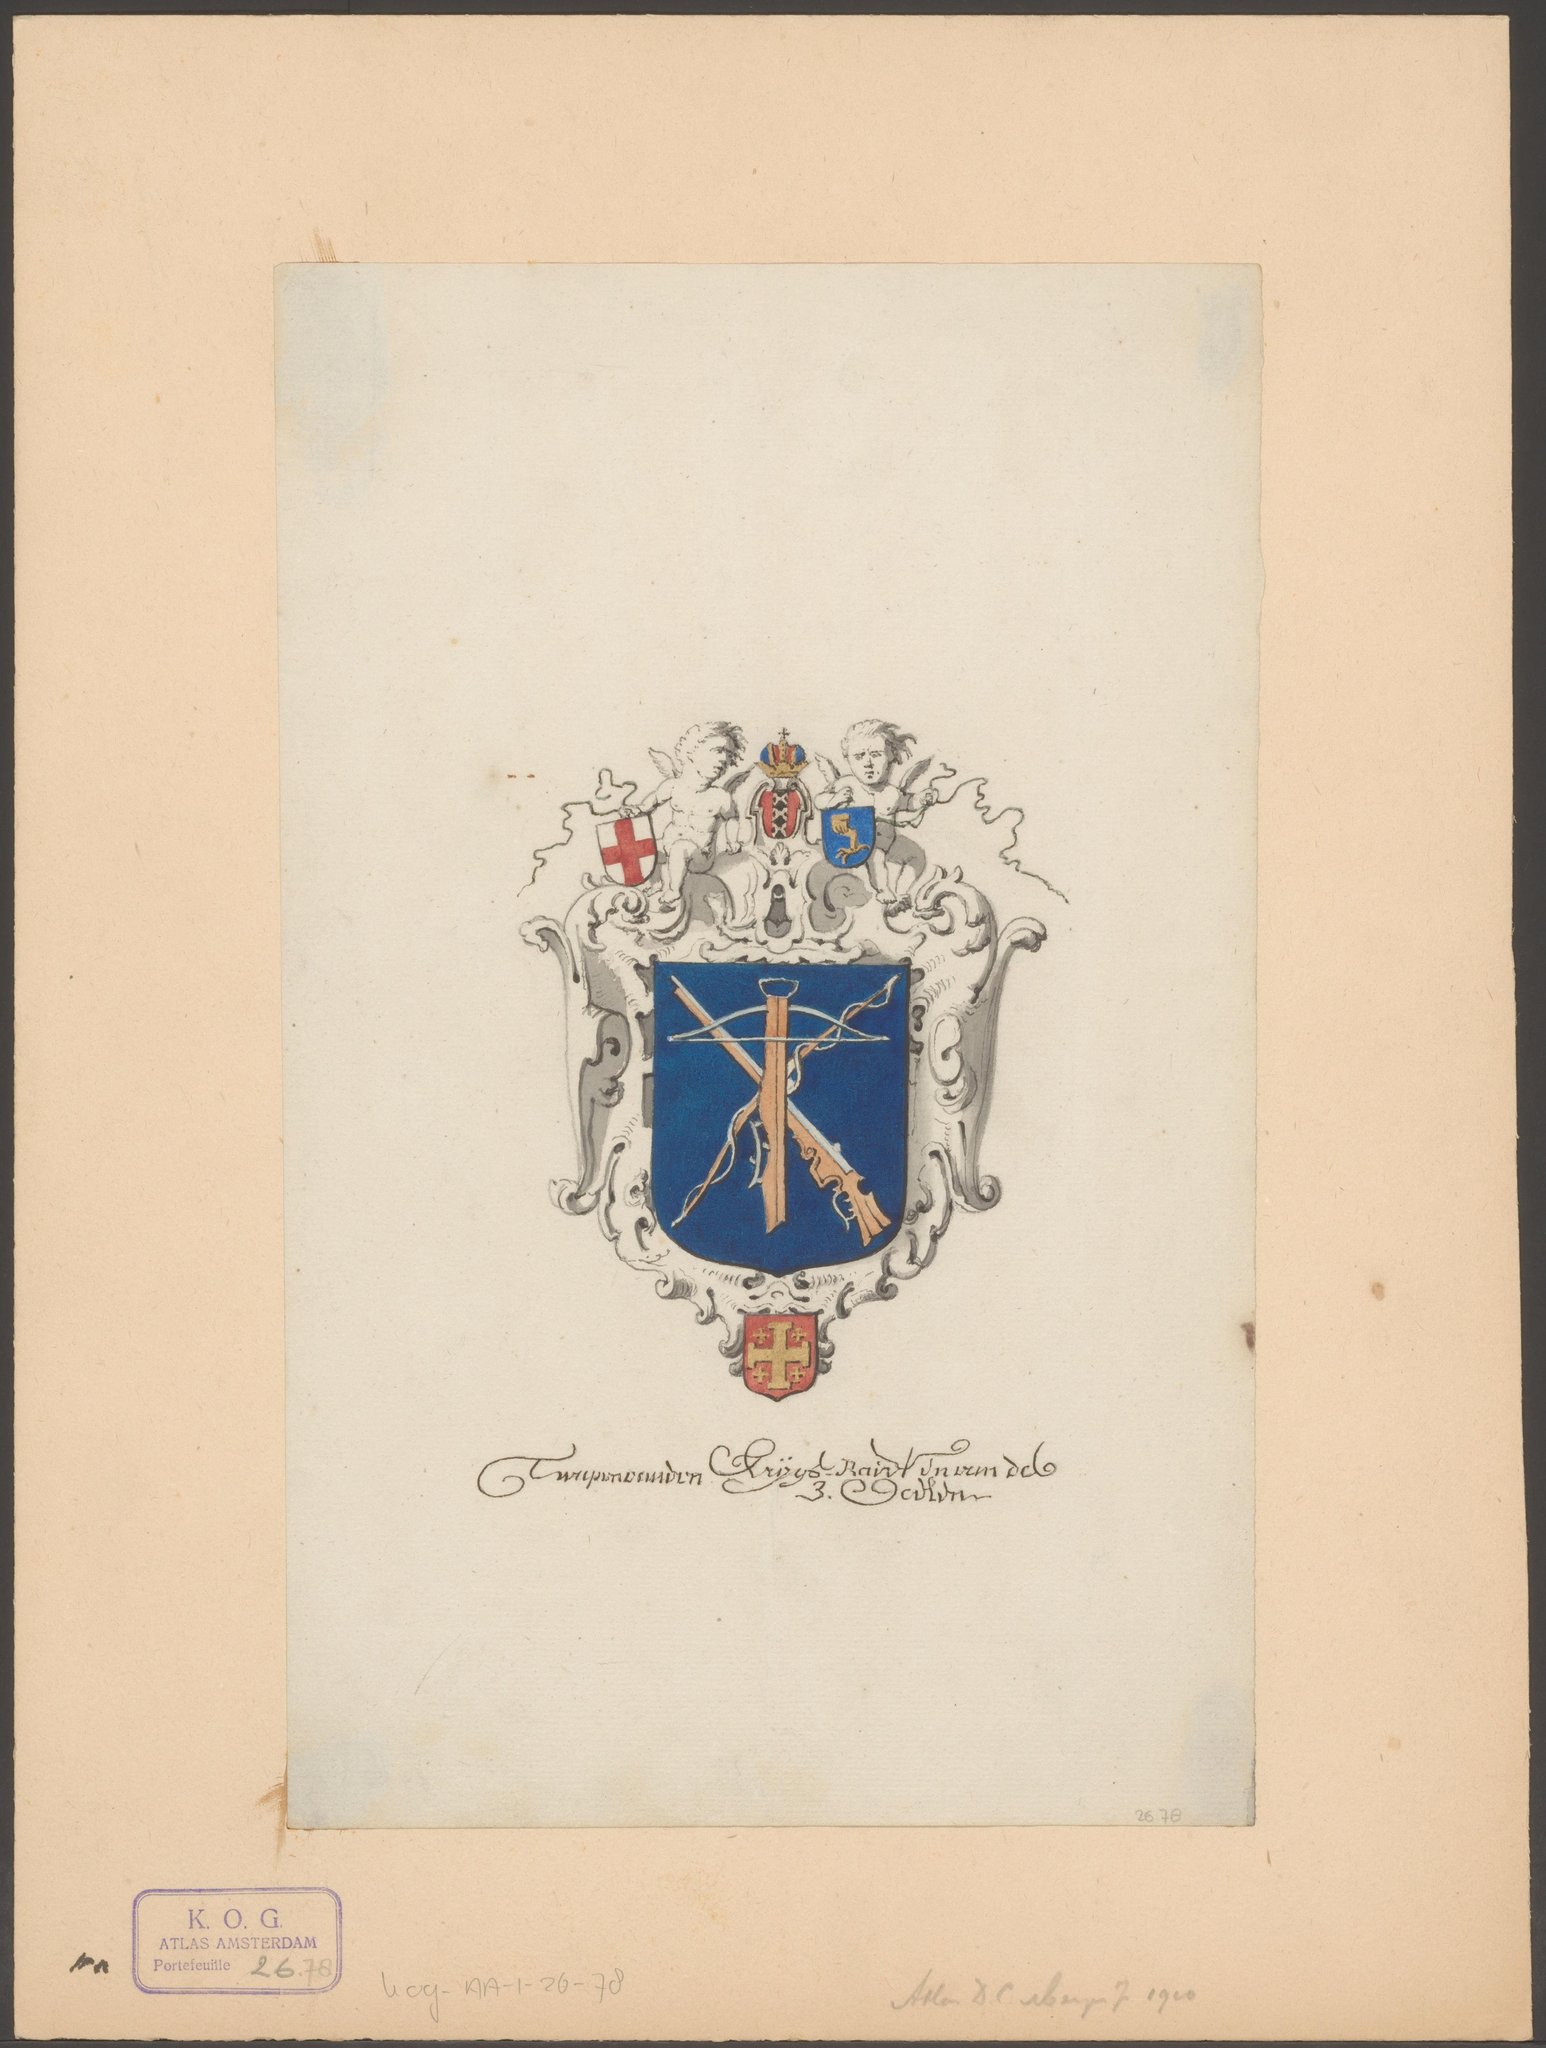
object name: drawing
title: Twapenvanden Krijgsraidt en van de 3. Doelen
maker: Anonymous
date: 1701-1800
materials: paint, ink, paper, pencil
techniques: brush, pen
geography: northern netherlands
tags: coat of arms (as symbol of the state, etc.) (+ city; municipal), armorial bearing, heraldry, amsterdam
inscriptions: collector's mark: Lugt 1641b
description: Blazoen met een schild met een vuurwapen, een handboog en een voetboog. Onderaan een schild met een Jeruzalemkruis. Bovenaan twee putti aan weerszijden van het wapen van Amsterdam, met links een schild met een Grieks kruis, en rechts een schild met een spoor. Onderwerpsrubriek binnen de Atlas Amsterdam: Herinneringen aan de Schutterij.